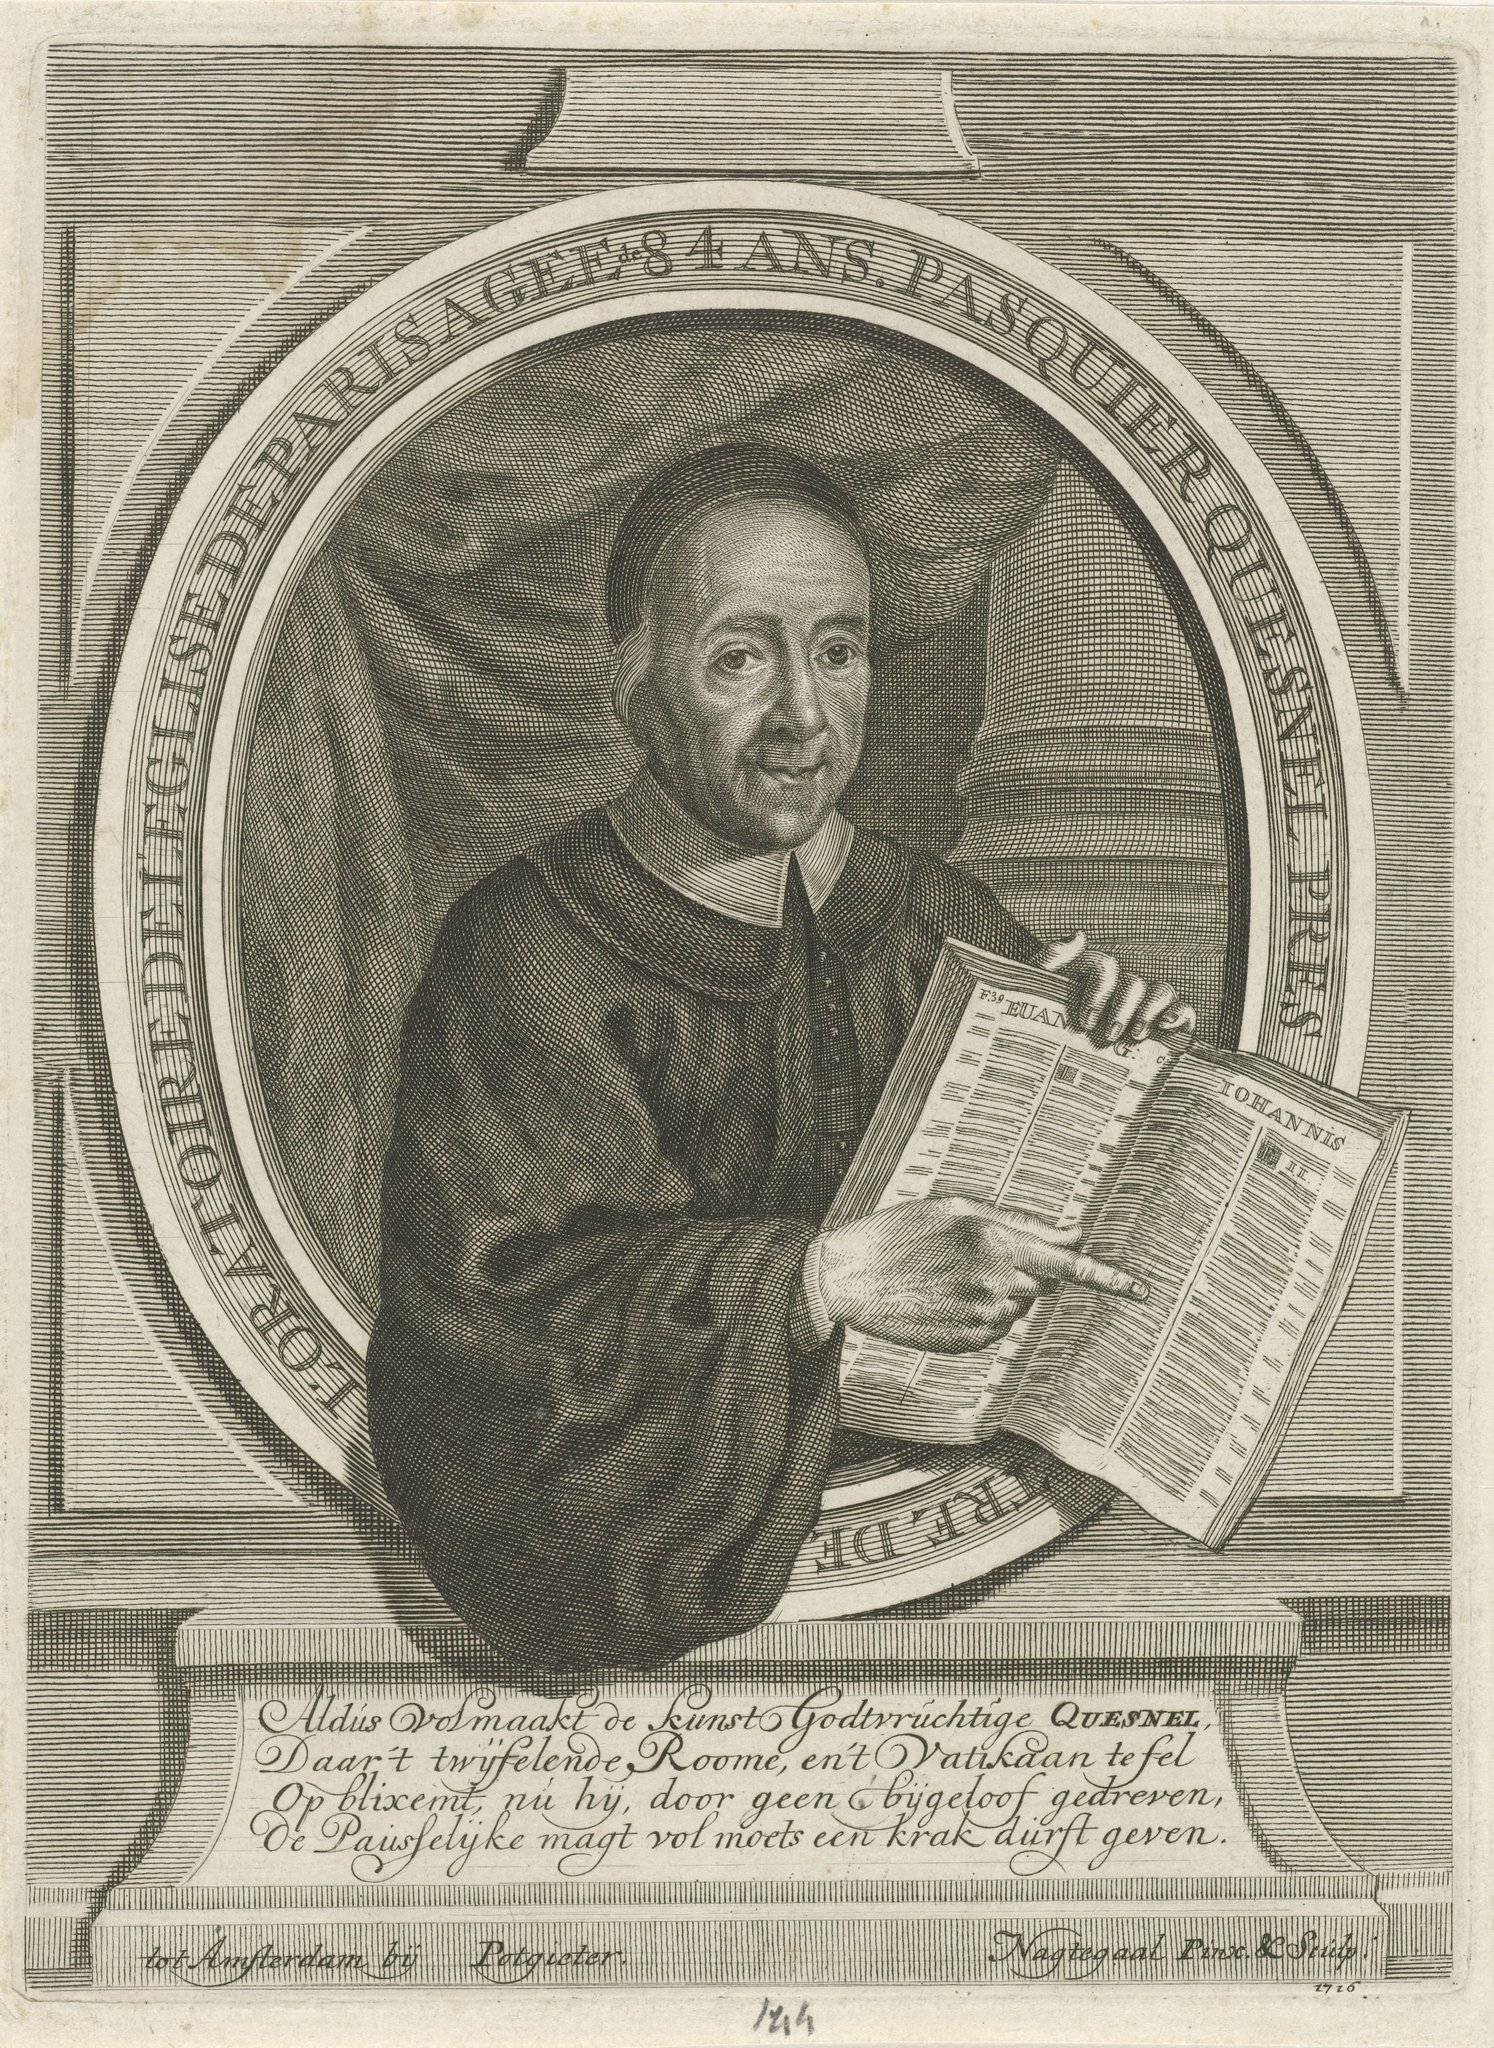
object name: print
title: Portret van Pasquier Quesnel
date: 1716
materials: paper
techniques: engraving, etching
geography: amsterdam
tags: theoloog, pasquier quesnel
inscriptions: collector's mark: Lugt 2228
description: Pasquier Quesnel, Frans theoloog en Jansenist, wijzend op het opengeslagen evangelie van Johannes. Portret ten halven lijve naar rechts in een ovaal met randtekst. Onderaan in de marge een vierregelig vers.